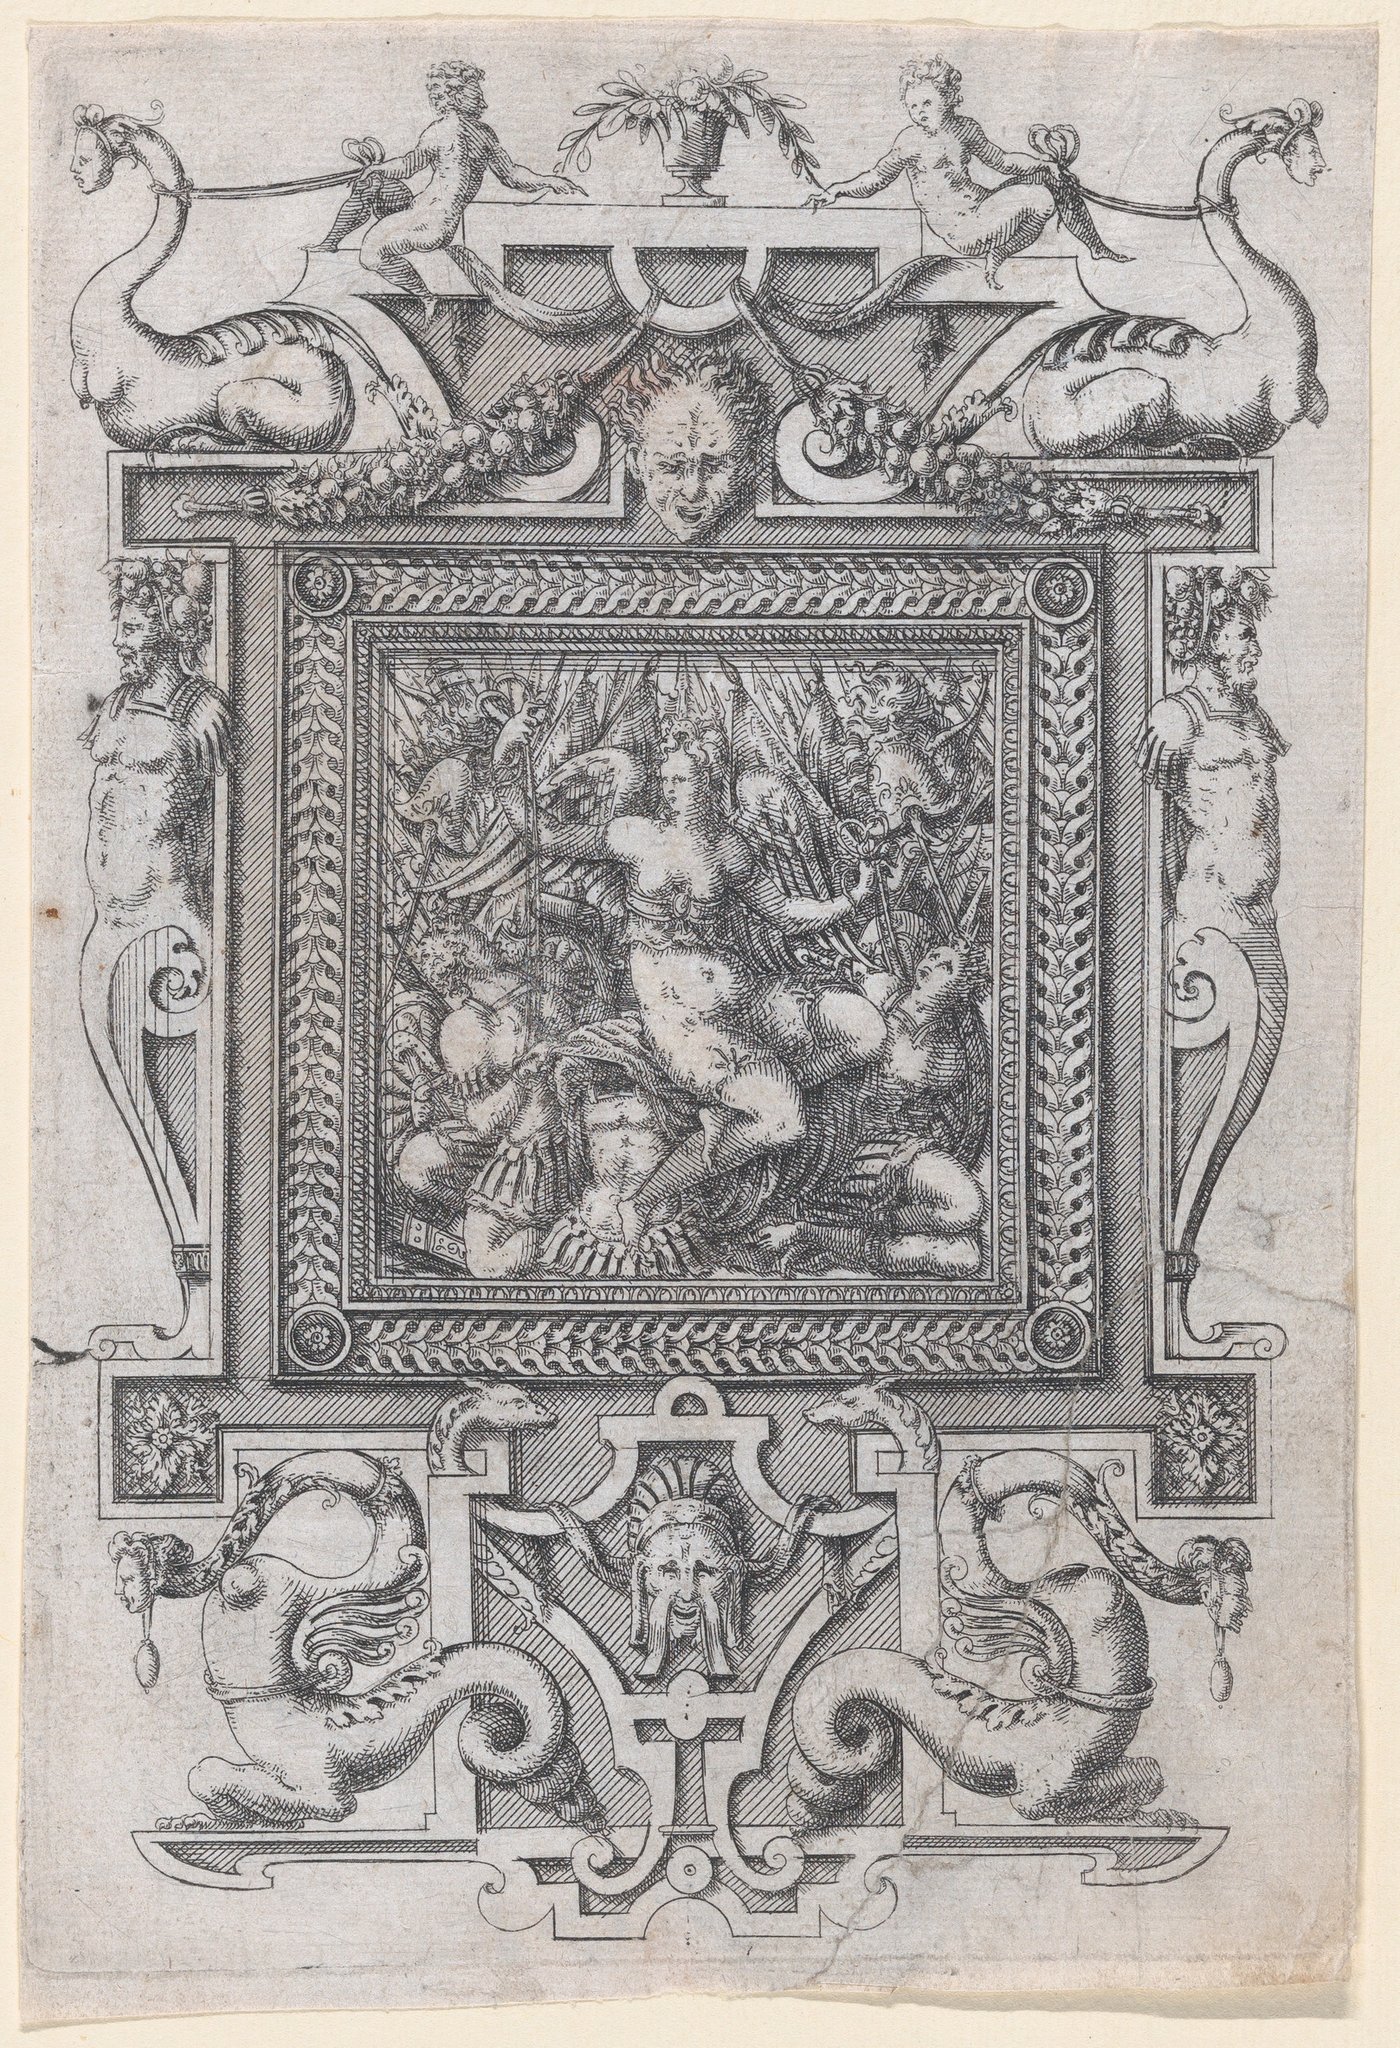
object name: print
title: Furniture Design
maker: jacques androuet du cerceau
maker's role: artist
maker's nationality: french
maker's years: 1510-1585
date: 1565-1570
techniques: etching